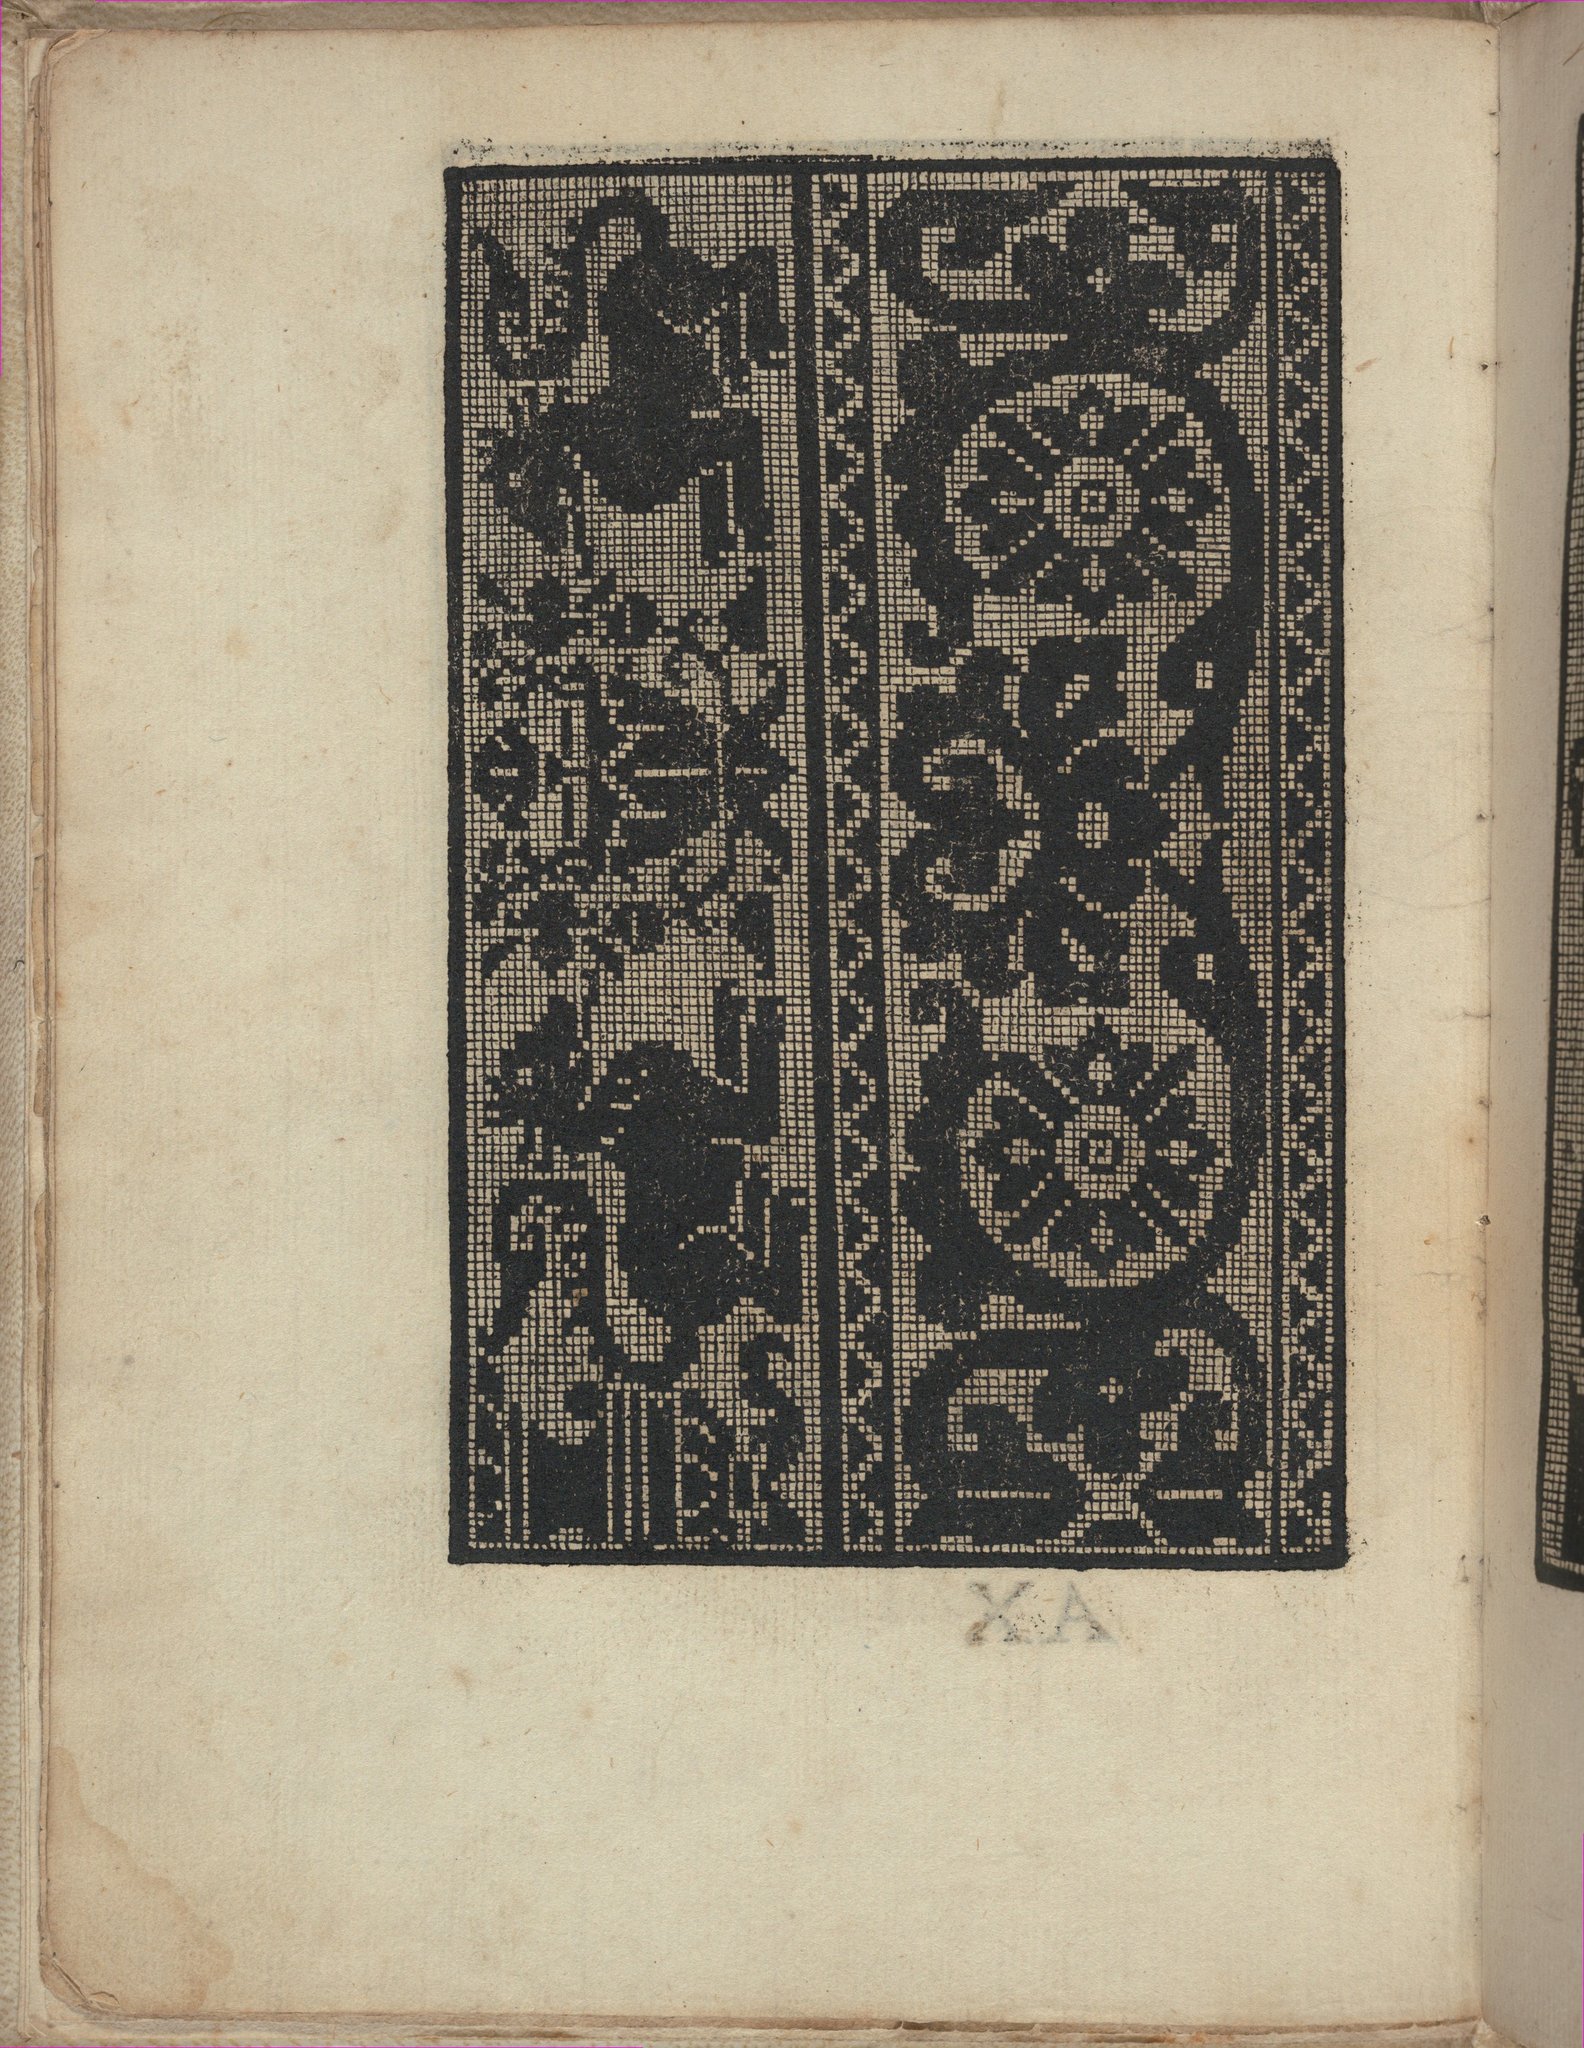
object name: book print ornament architecture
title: Esemplario di Lauori..., page 6 (verso)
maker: giovanni andrea vavassore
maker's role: publisher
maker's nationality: italian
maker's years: 1530-1573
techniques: woodcut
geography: venice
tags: griffins